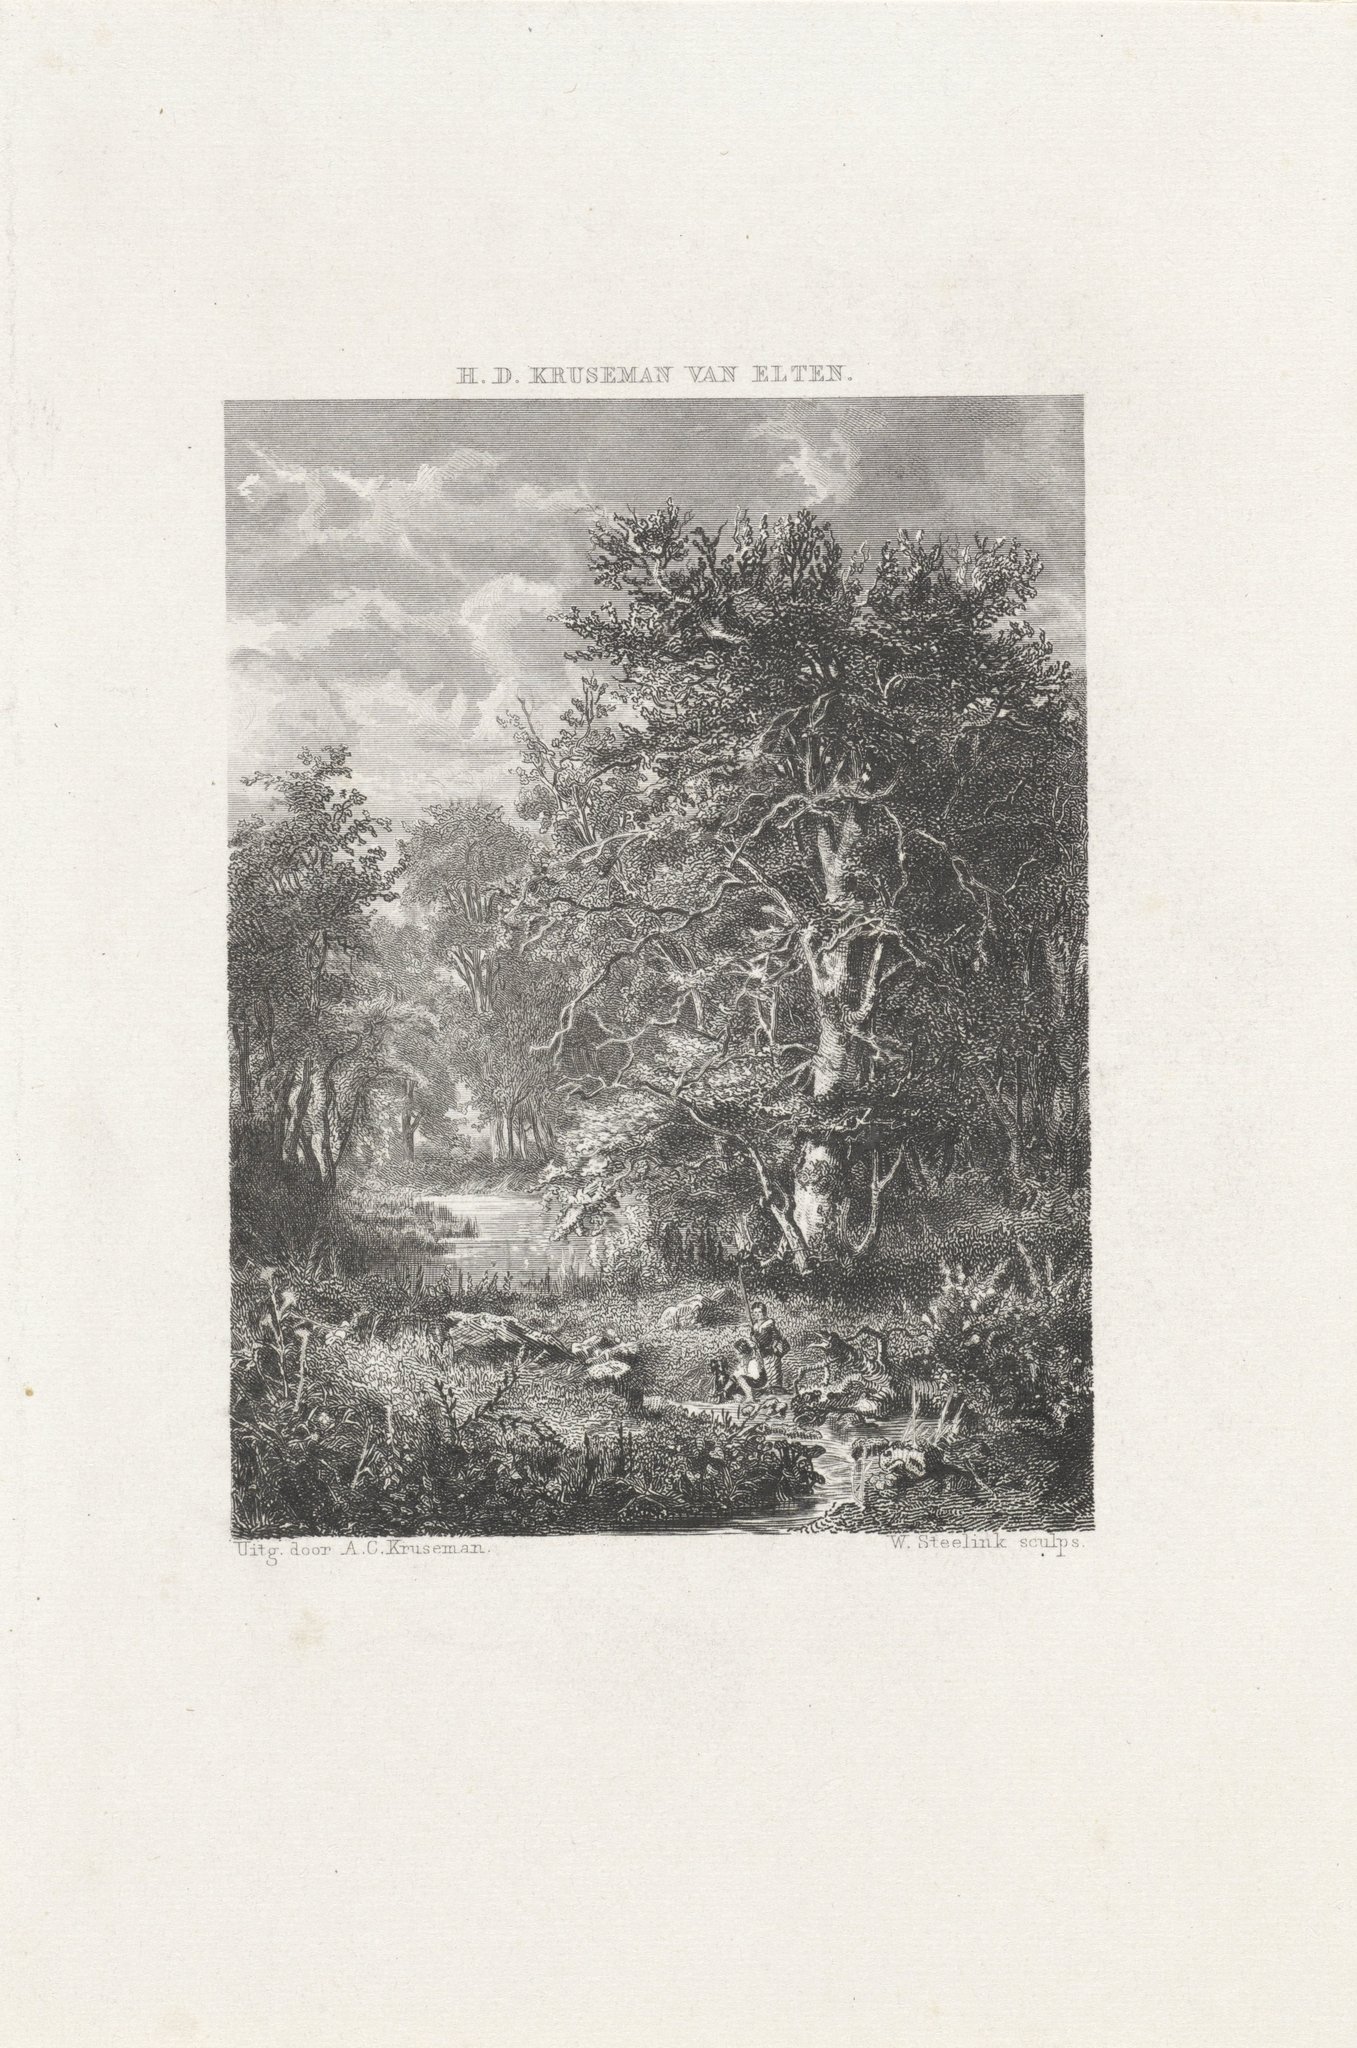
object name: print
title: Landschap met twee jongens en een hond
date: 1856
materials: paper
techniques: etching, engraving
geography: haarlem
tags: trees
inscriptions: collector's mark: Lugt 2228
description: Illustratie voor: Aurora. Jaarboekje voor 1856. Haarlem: Arie Cornelis Kruseman, 1856.